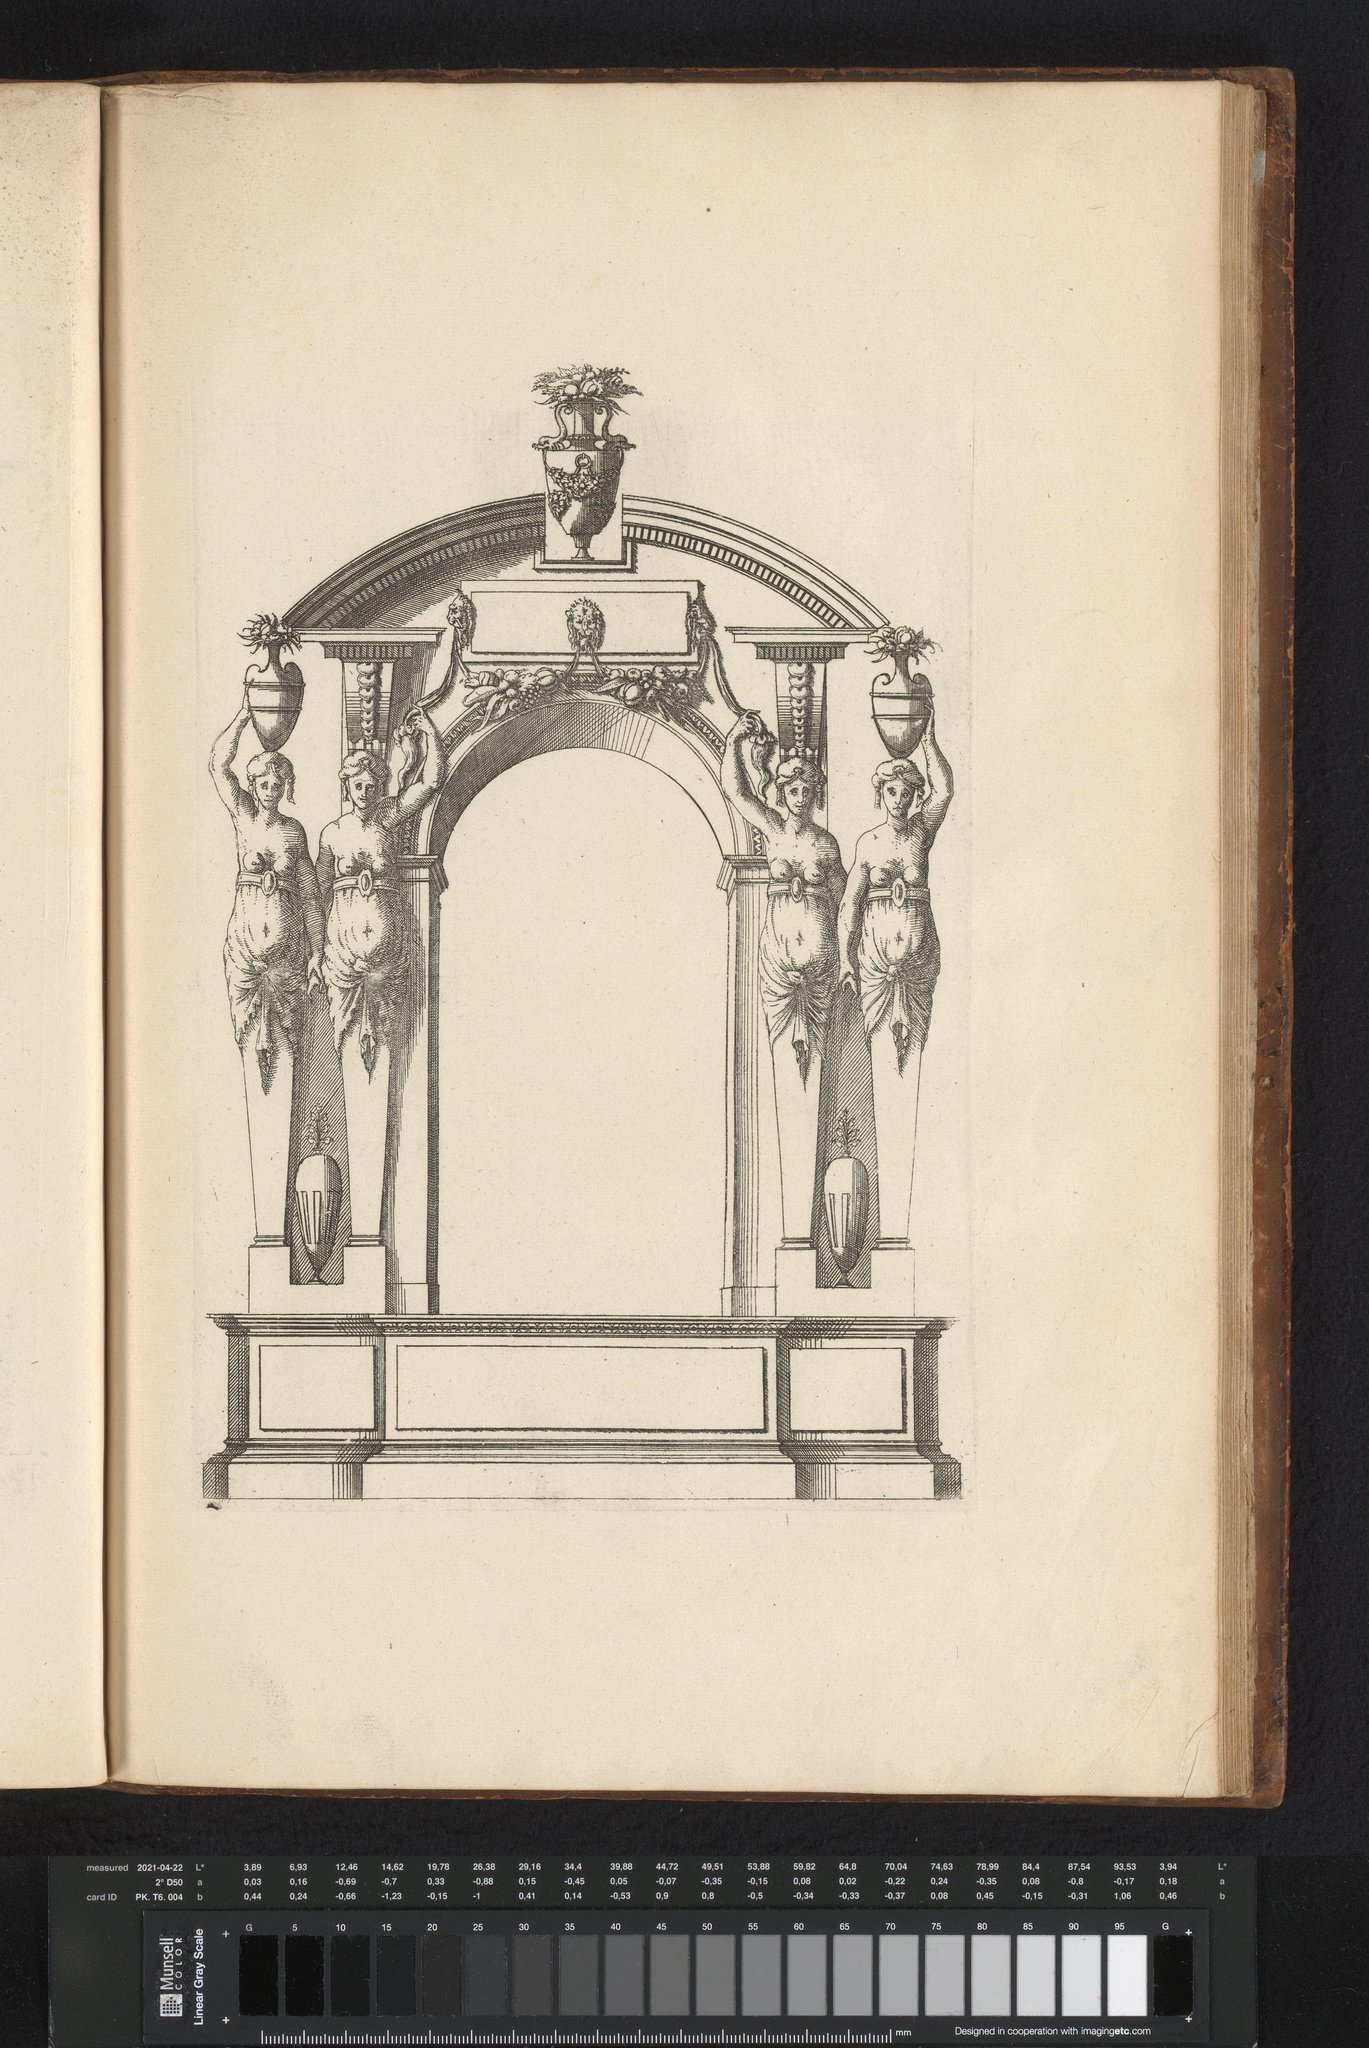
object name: ornament print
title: Dakraam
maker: jacques androuet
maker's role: draughtsman, print maker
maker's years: 1515-1584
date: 1561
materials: paper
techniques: etching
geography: paris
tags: window, architectural representations in general, caryatids ~ architecture, arch, archivolt ~ architecture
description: Dakraam met aan weerszijden kariatiden. Onderdeel van 'Seconde livre d'architectvre' (1561): 64 etsen met geornamenteerde architectuuronderdelen.